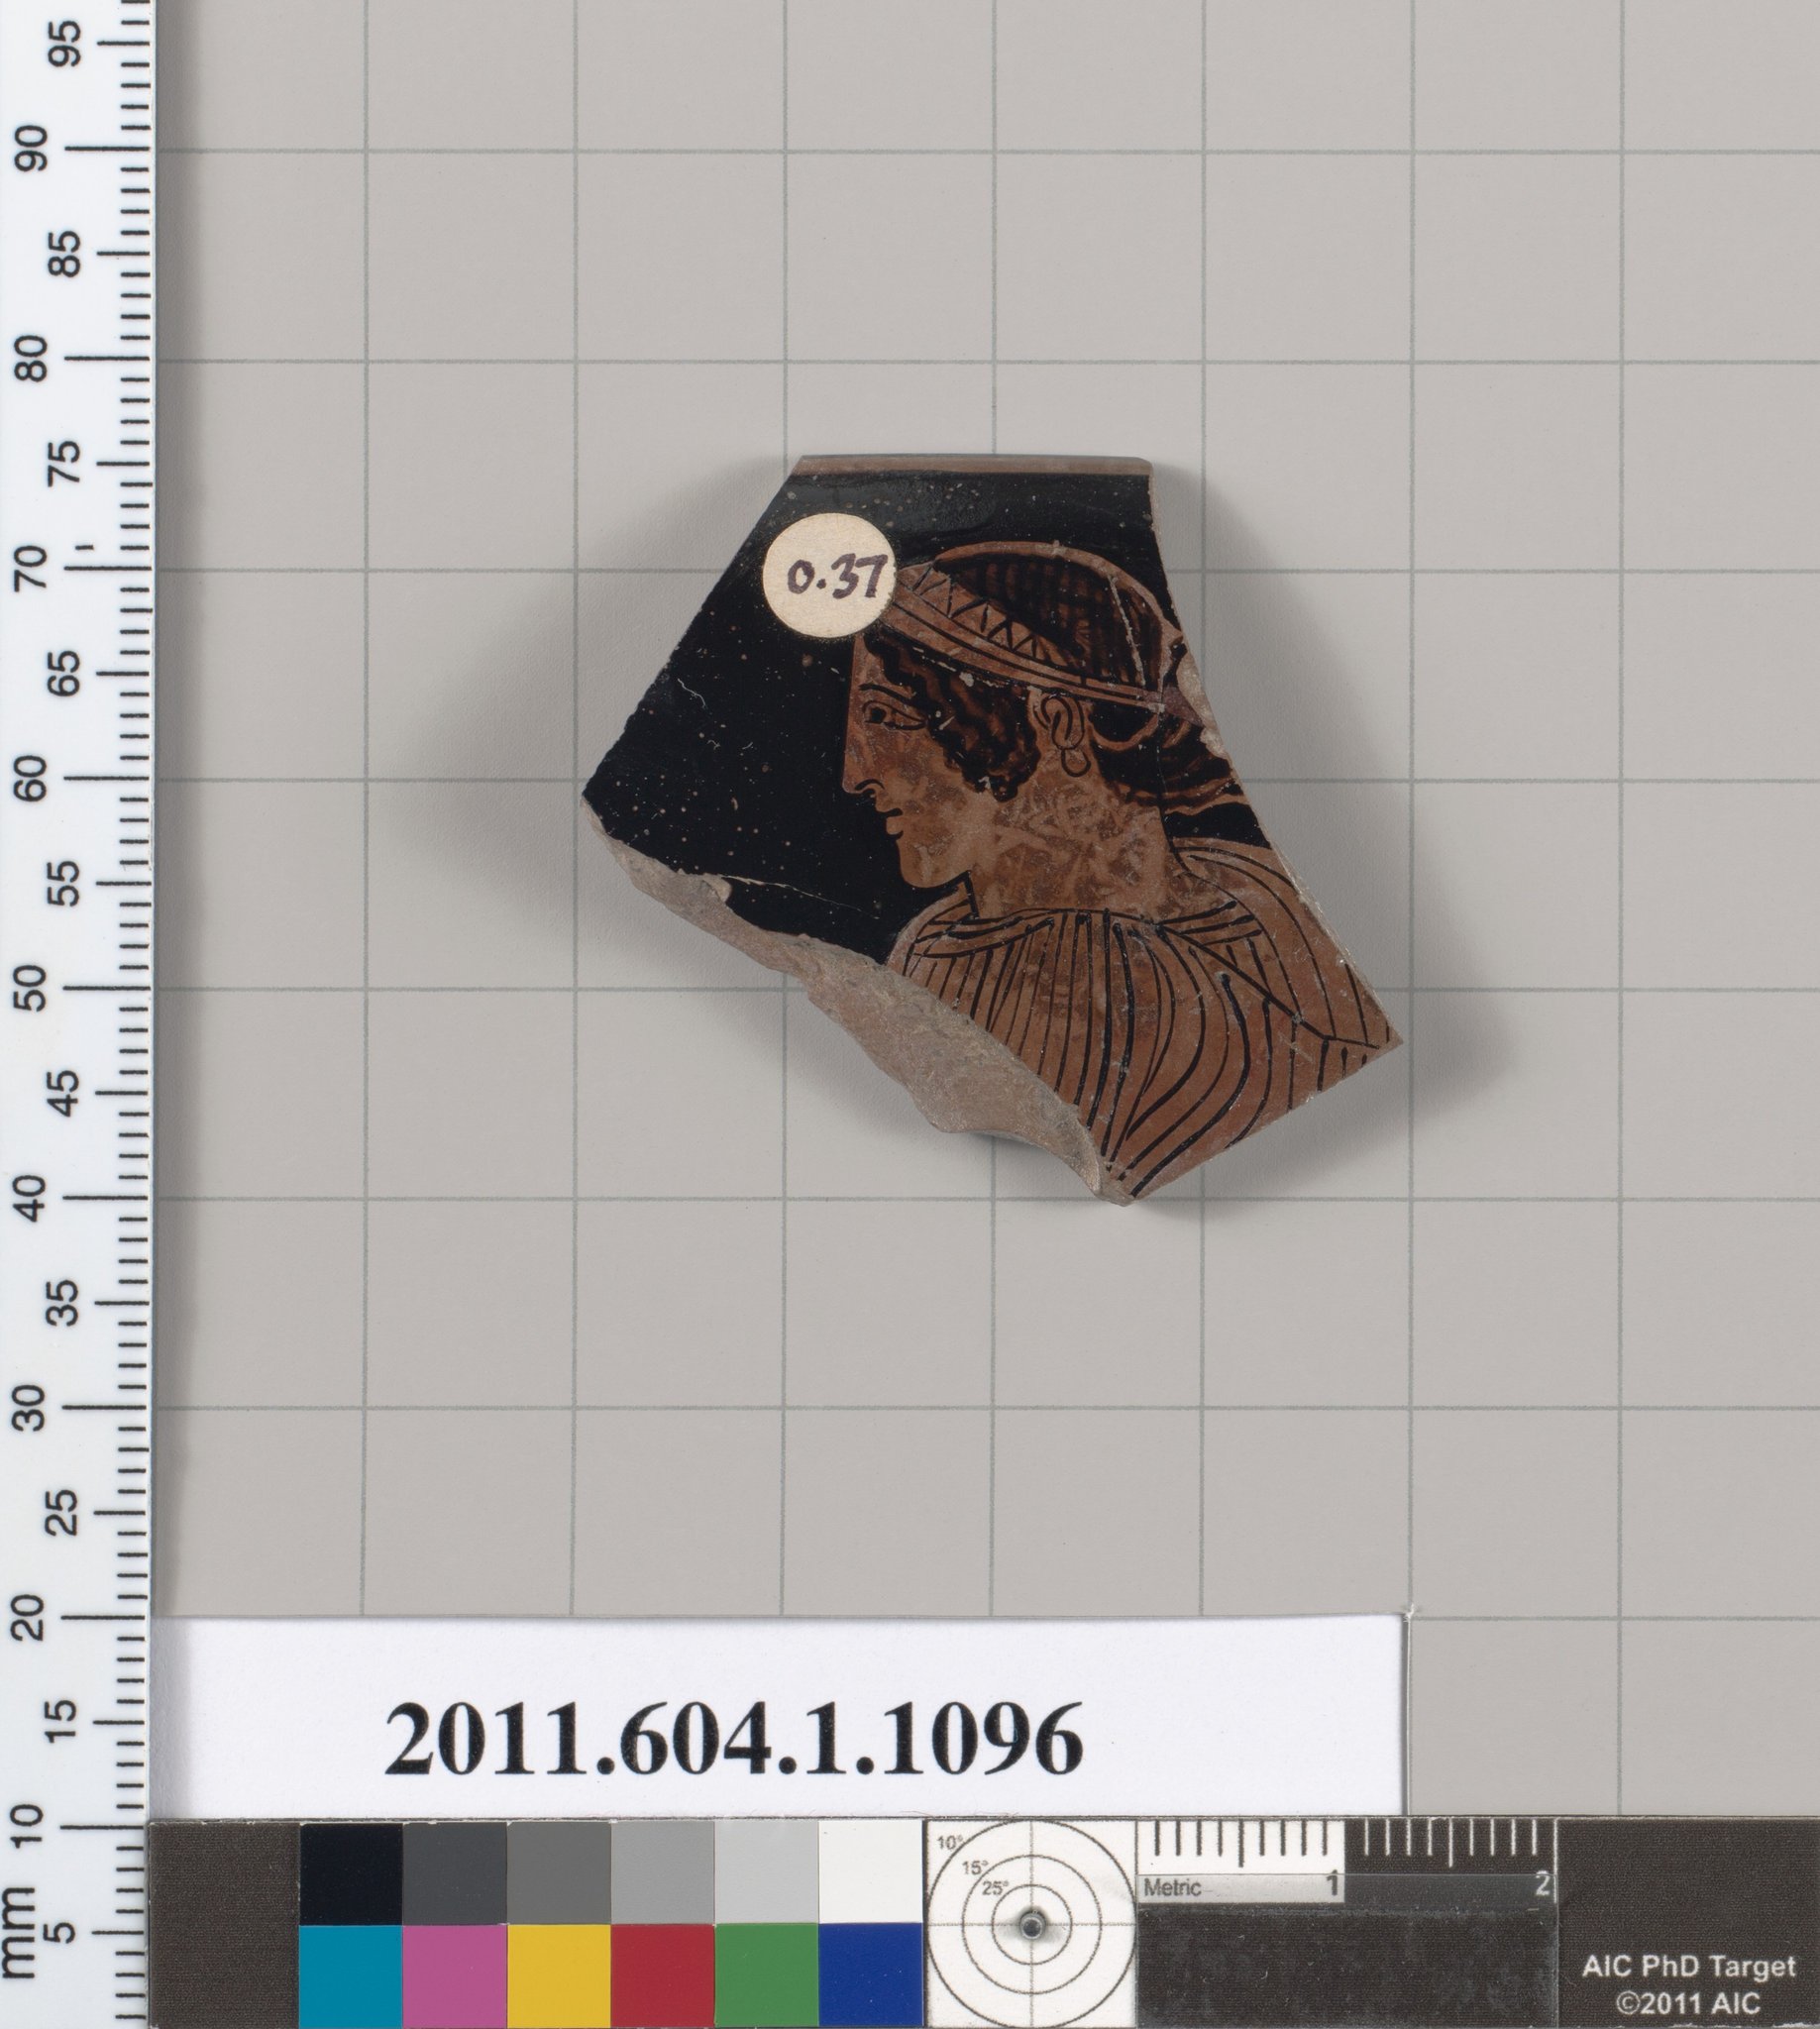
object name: kylix fragment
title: Terracotta rim fragment of a kylix (drinking cup)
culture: greek, attic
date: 475-451 BCE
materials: terracotta